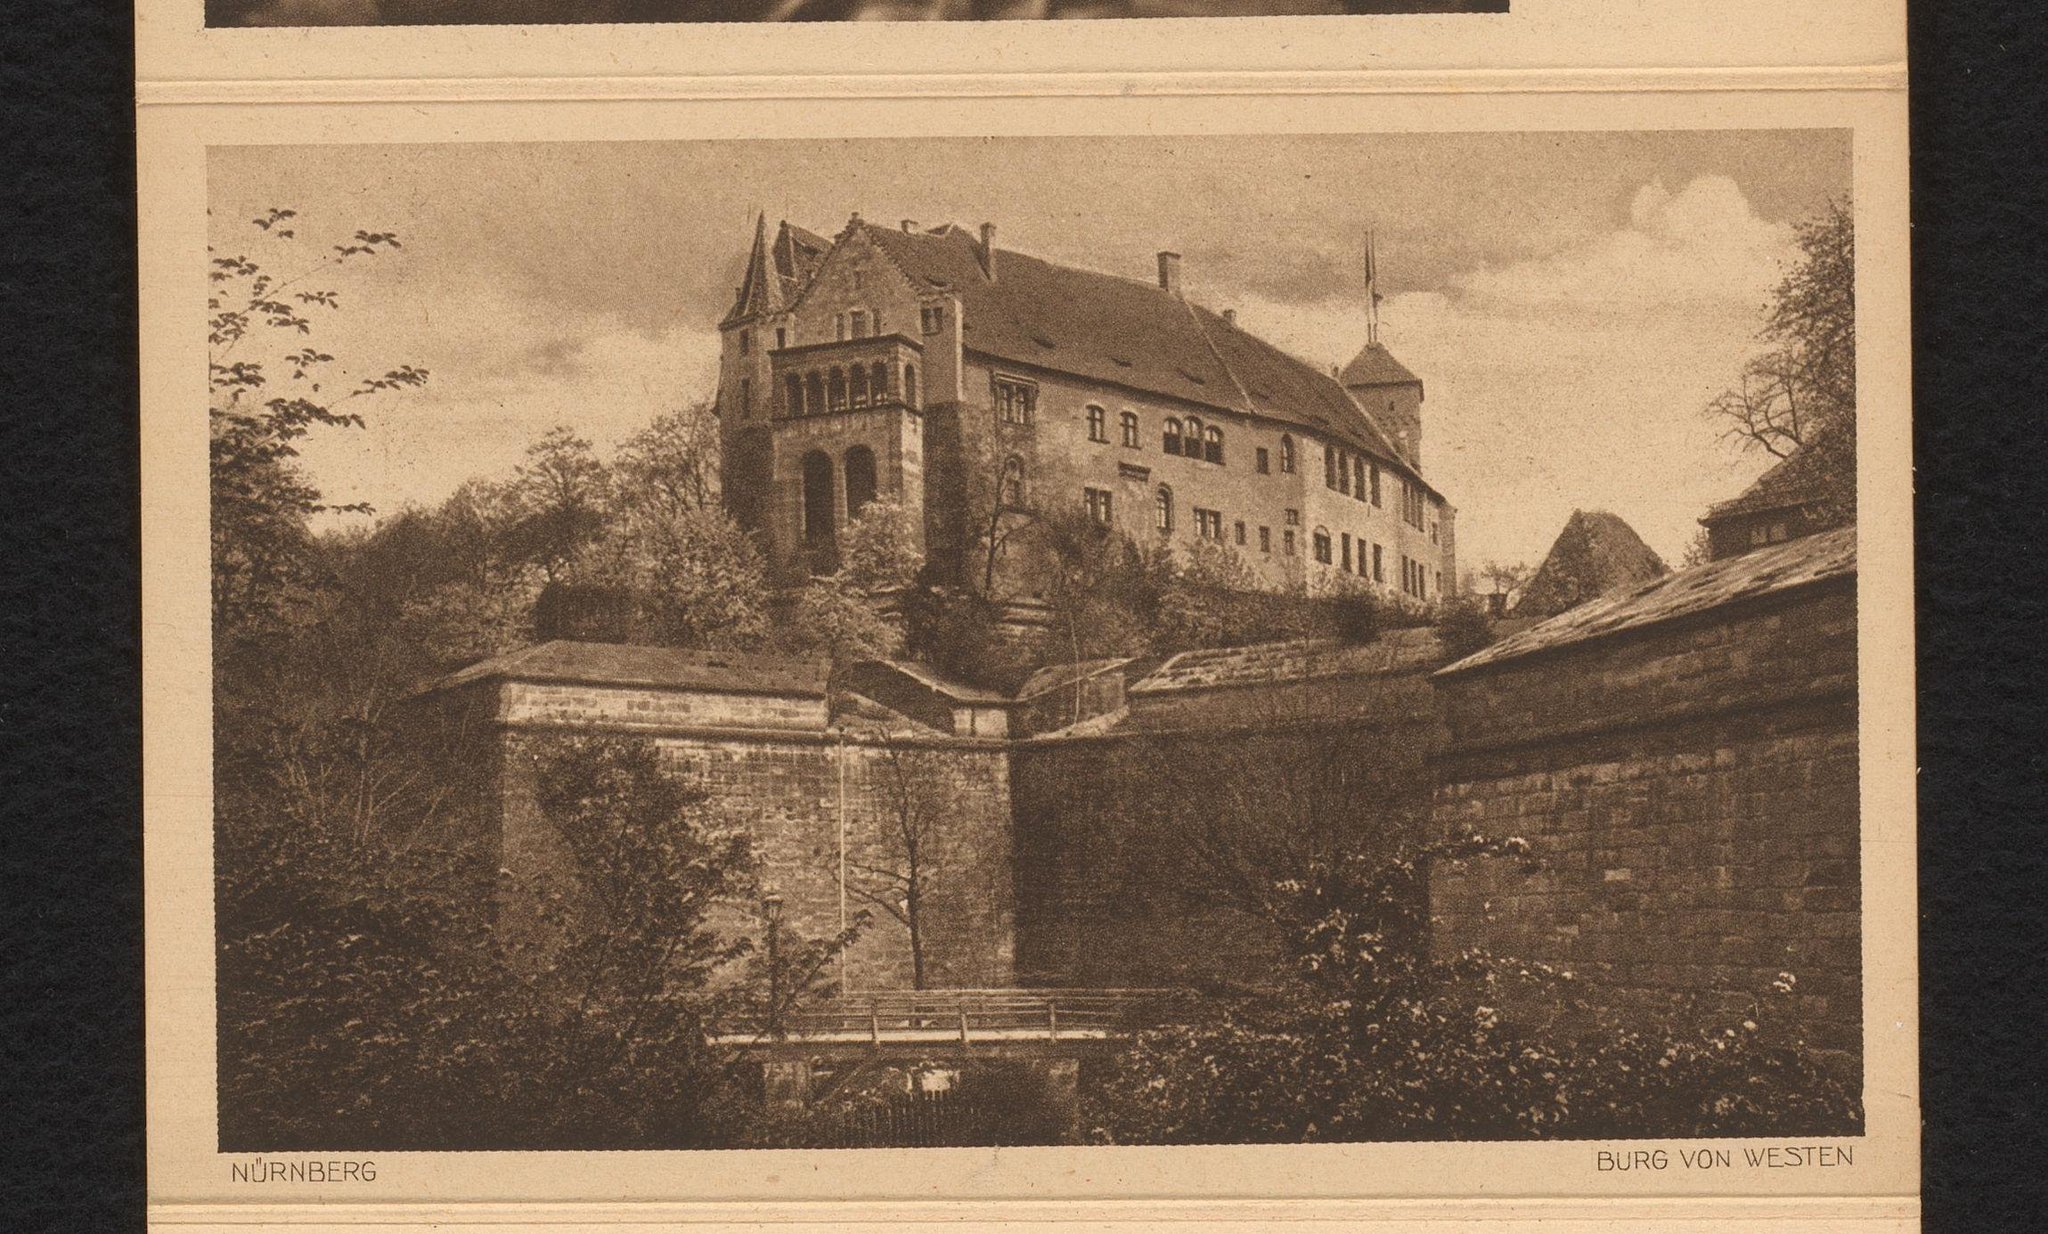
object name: photomechanical print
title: Nürnberg. Burg von Westen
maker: Anonymous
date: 1905-1930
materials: cardboard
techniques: rotogravure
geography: nuremberg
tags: castle